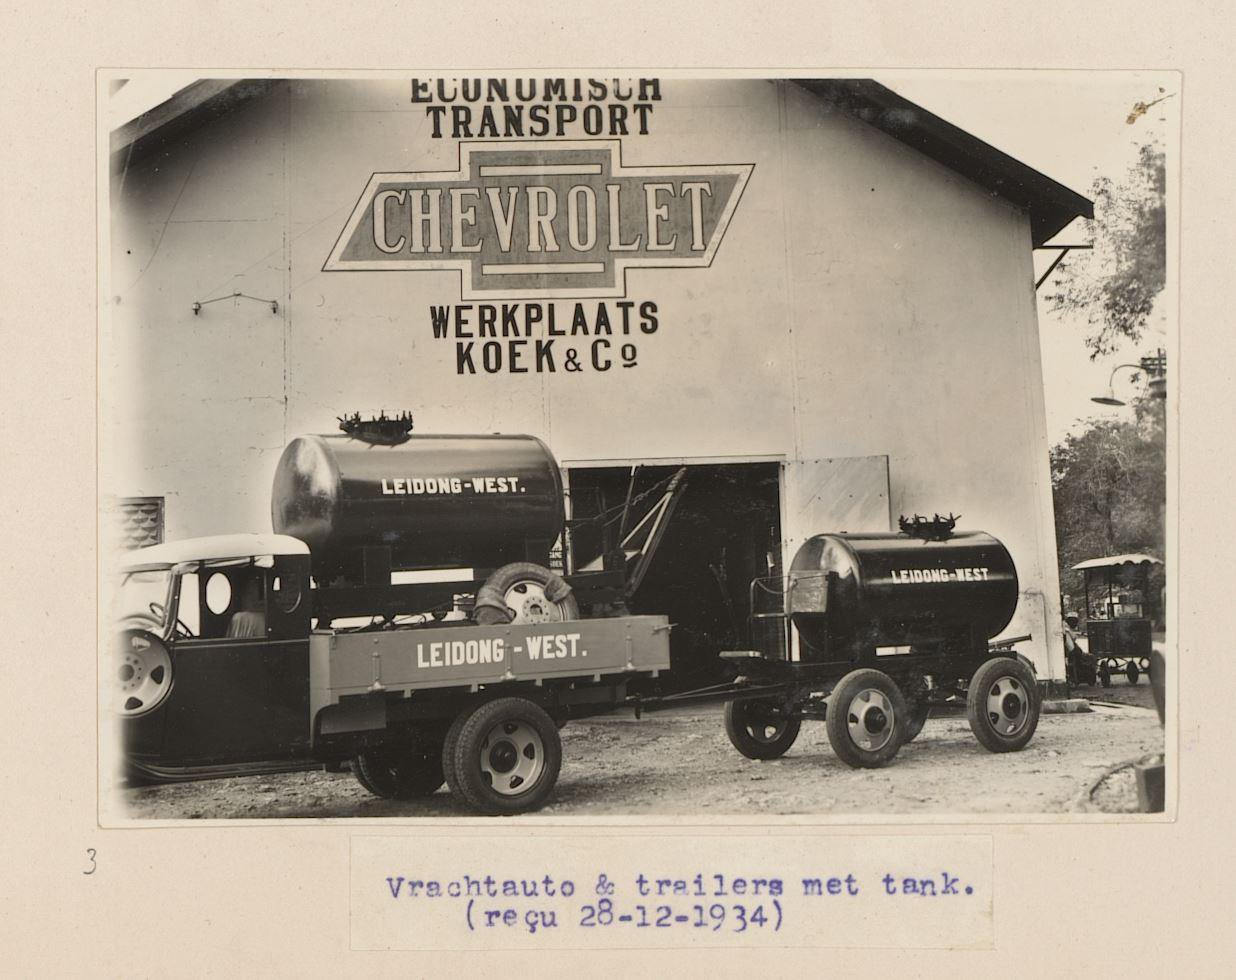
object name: photograph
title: Vrachtauto & trailers met tank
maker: Anonymous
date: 1934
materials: photographic support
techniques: gelatin silver print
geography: sumatra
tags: truck, van, plantation, (non-fruit) products of plants or trees: rubber, sumatra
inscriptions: inscription: ‘Vrachtauto & trailers met tank. (reçu 28-12-1934)’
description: Vrachtauto en trailers van de onderneming Leidong West bij de werkplaats Koek & Co. in 1934. Onderdeel van het fotoalbum over de plantages Leidong West en Kanopan Oeloe van de Cultuur Maatschappij Leidong West op Sumatra in de jaren 1925-1939.